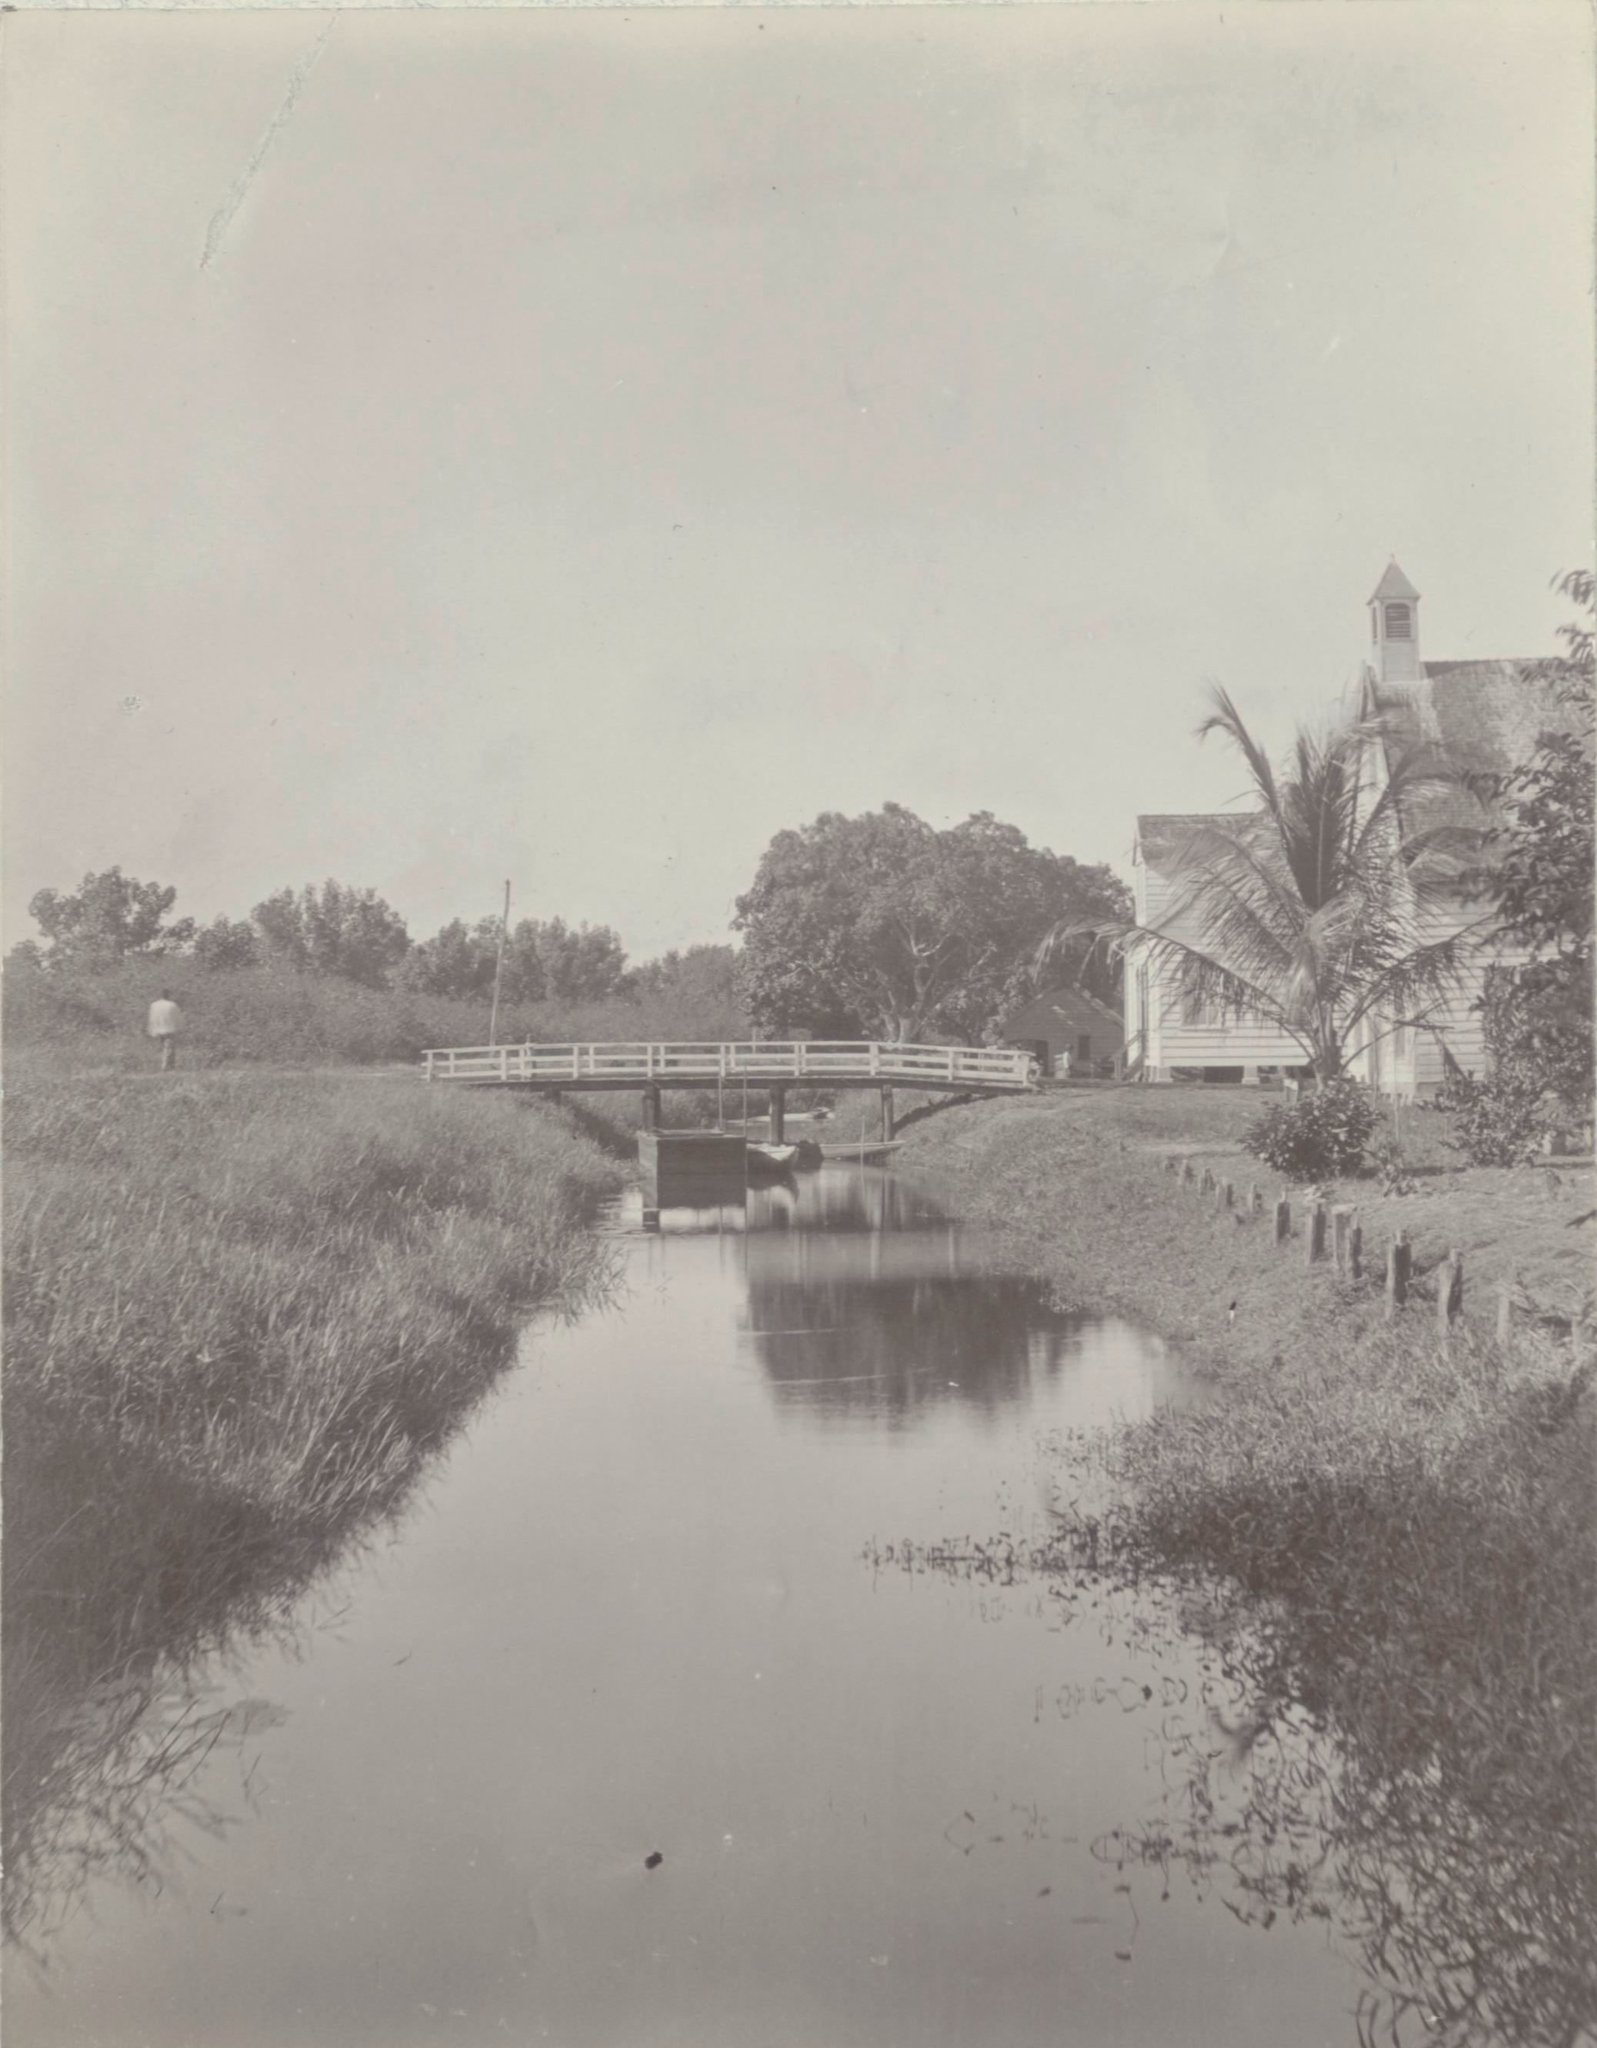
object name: photograph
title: Plantage Morgenstond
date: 1908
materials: photographic support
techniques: photography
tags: plantation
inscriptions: inscription: ‘Gezicht op vaarkens met bruggetje op Plantage "Morgenstond". Aug. 1908 P'bo.’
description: Gezicht op een vaart bij Plantage Morgenstond in Paramaribo, augustus 1908. Onderdeel van het fotoalbum van de familie Boom-Gonggrijp in Suriname en Curaçao.